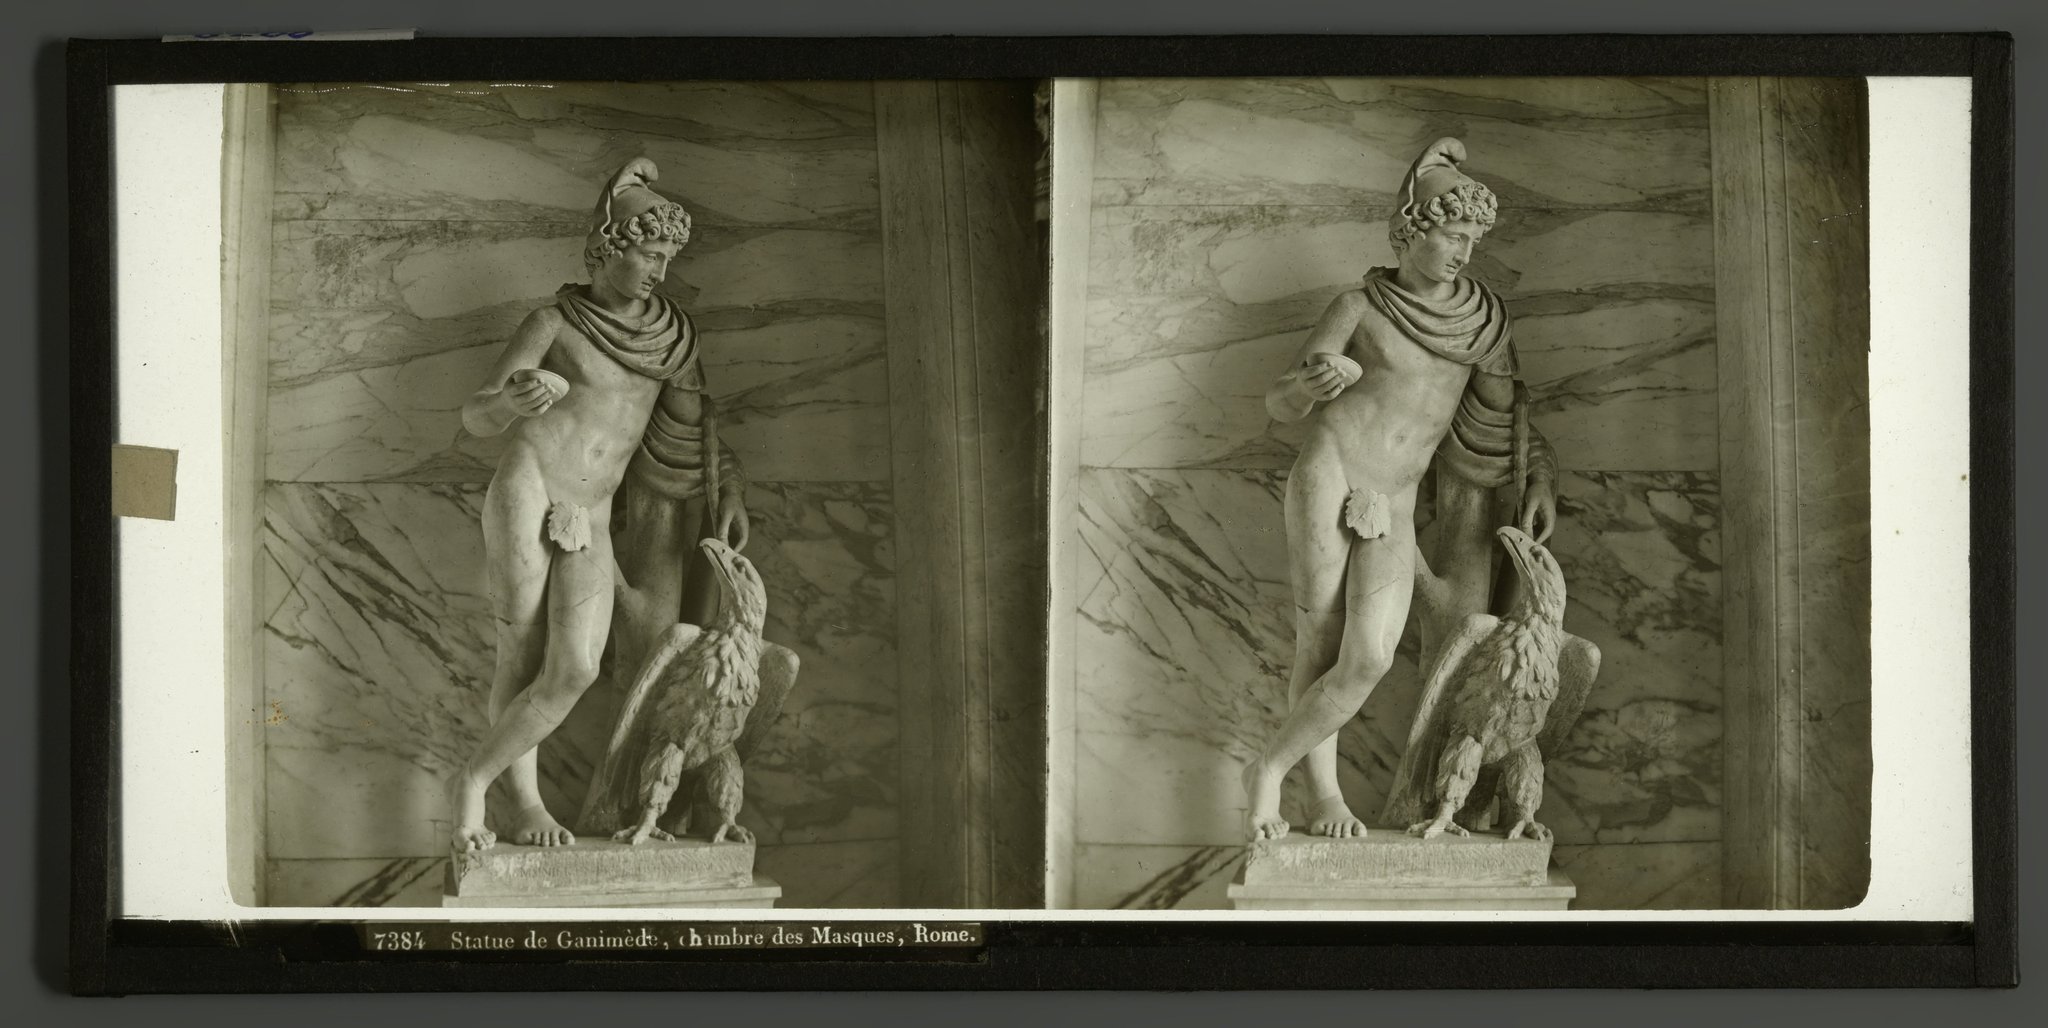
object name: stereoscopic photograph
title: Standbeeld van Ganymedes te Rome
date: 1860-1870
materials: glass, paper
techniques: slide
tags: (story of) ganymede, sculpture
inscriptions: inscription: ‘7384 Statue de Ganimede, chambre des Masques, Rome’